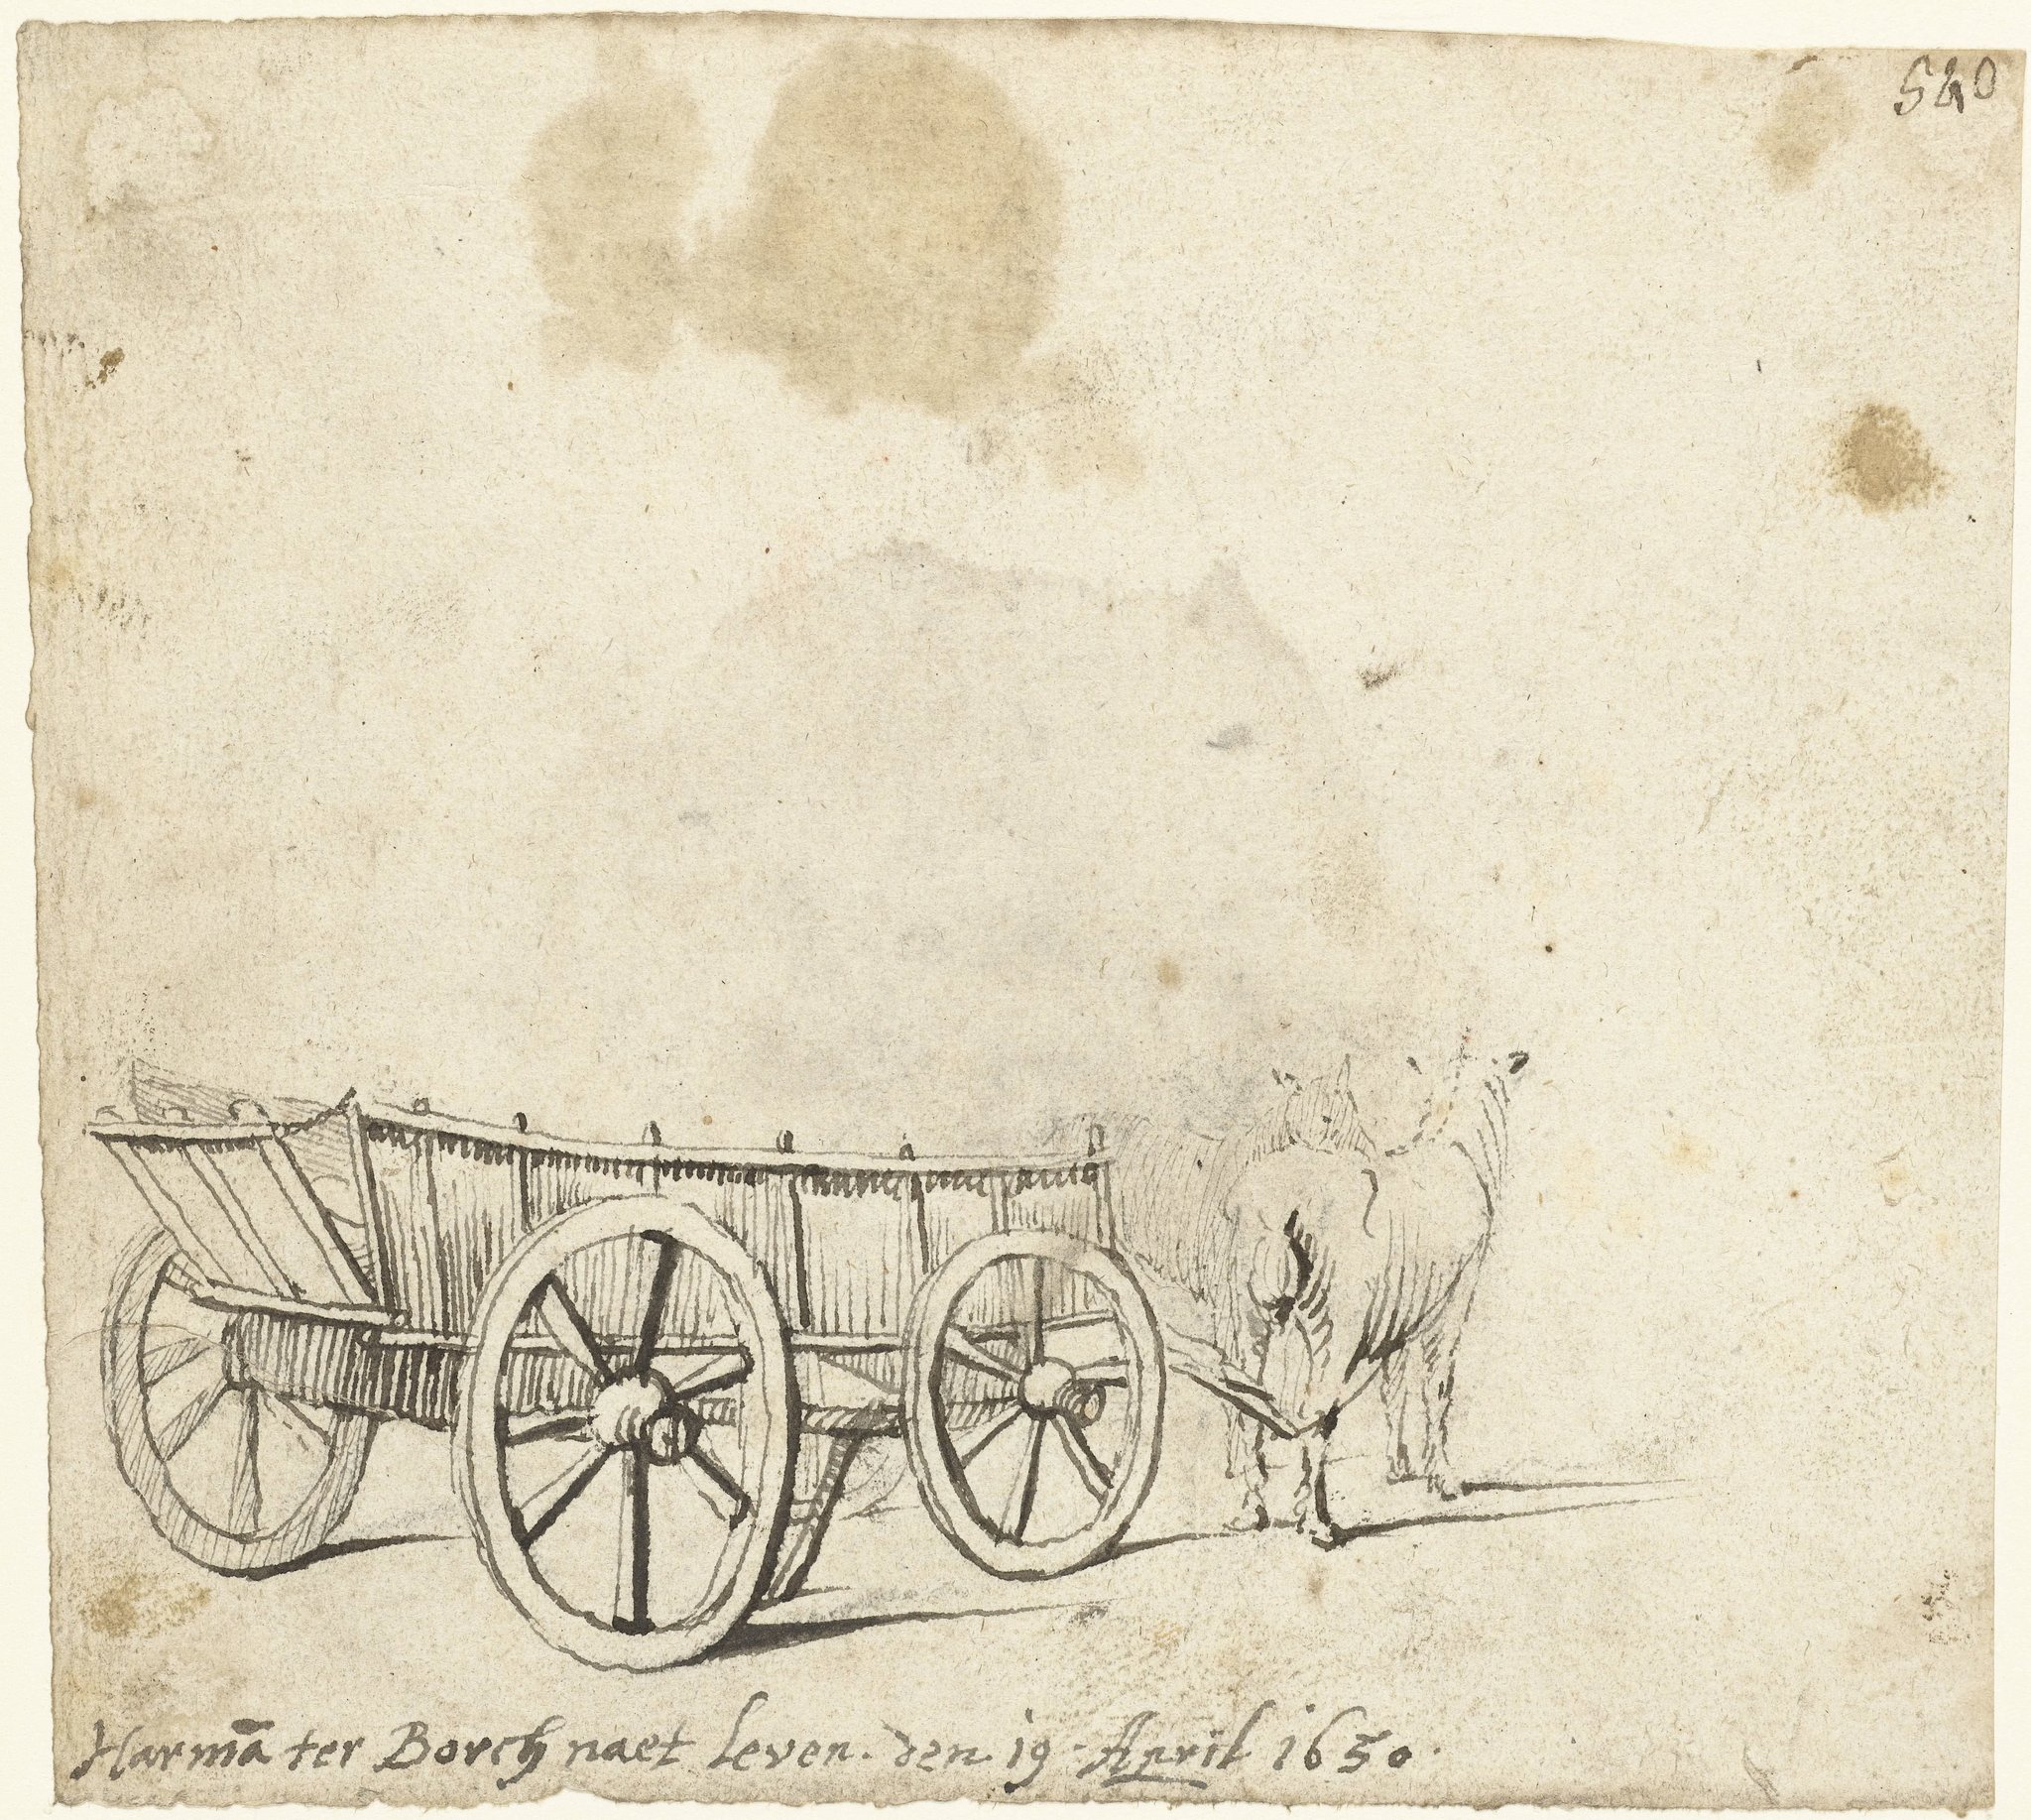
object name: drawing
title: Kar met paarden ervoor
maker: harmen ter borch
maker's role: draughtsman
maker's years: 1638-1677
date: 1650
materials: ink, paper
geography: zwolle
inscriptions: annotation: ‘Harma[n] ter Borch naet leven. den 19.April 1650.’